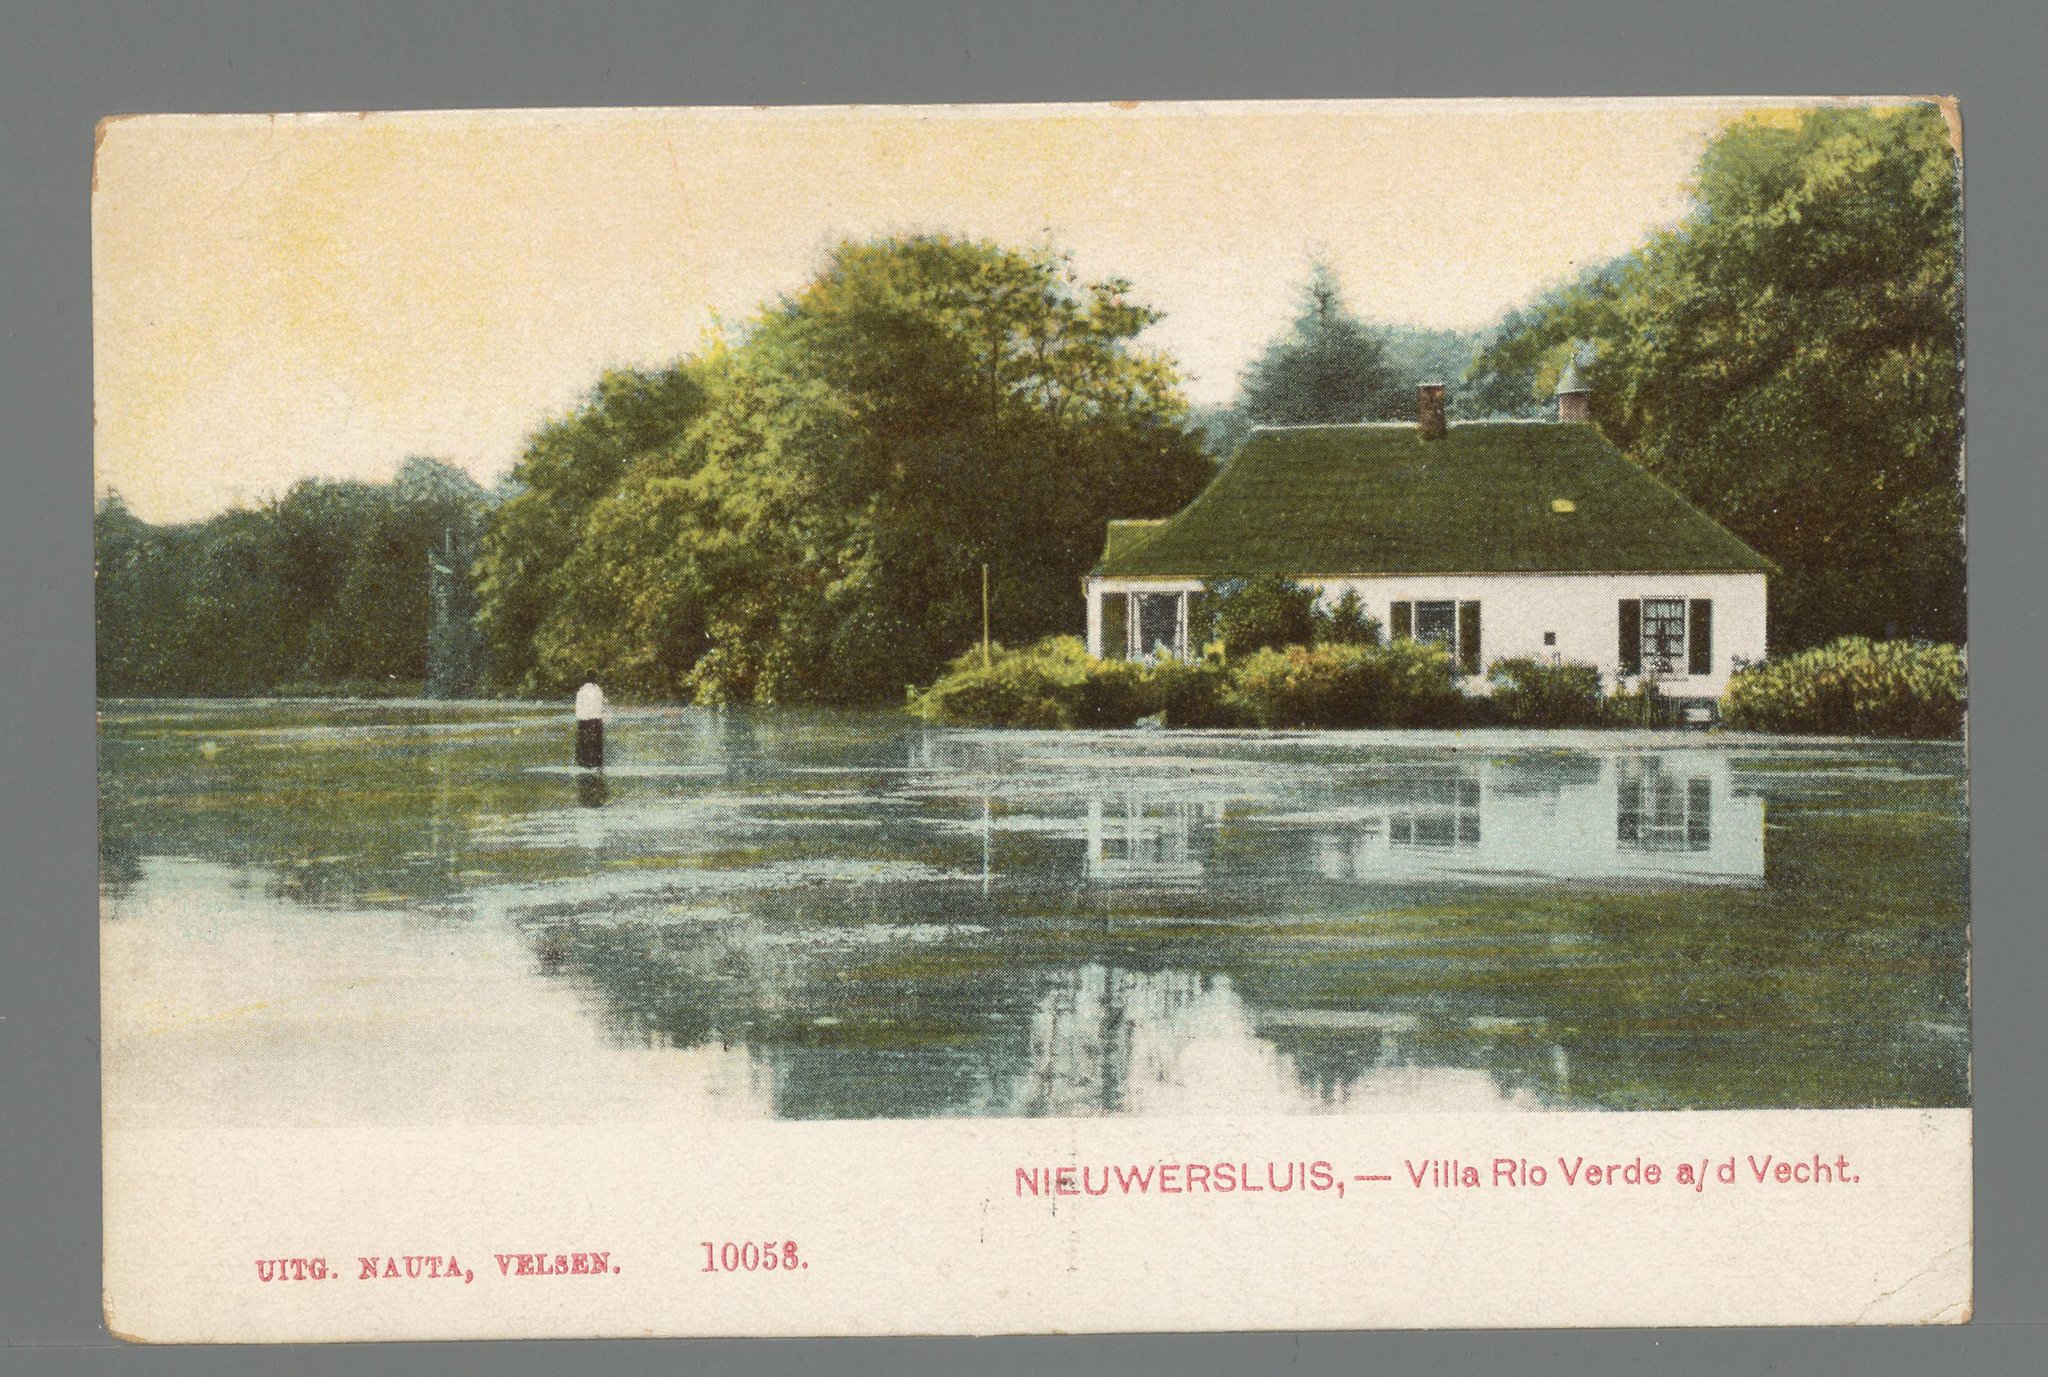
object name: ansichtkaart, prentbriefkaart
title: Nieuwersluis,- Villa Rio Verde a/ d Vecht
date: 1905-1913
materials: cardboard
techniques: lithograph, writing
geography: loenen aan de vecht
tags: river, villa, vecht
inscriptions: postage stamp